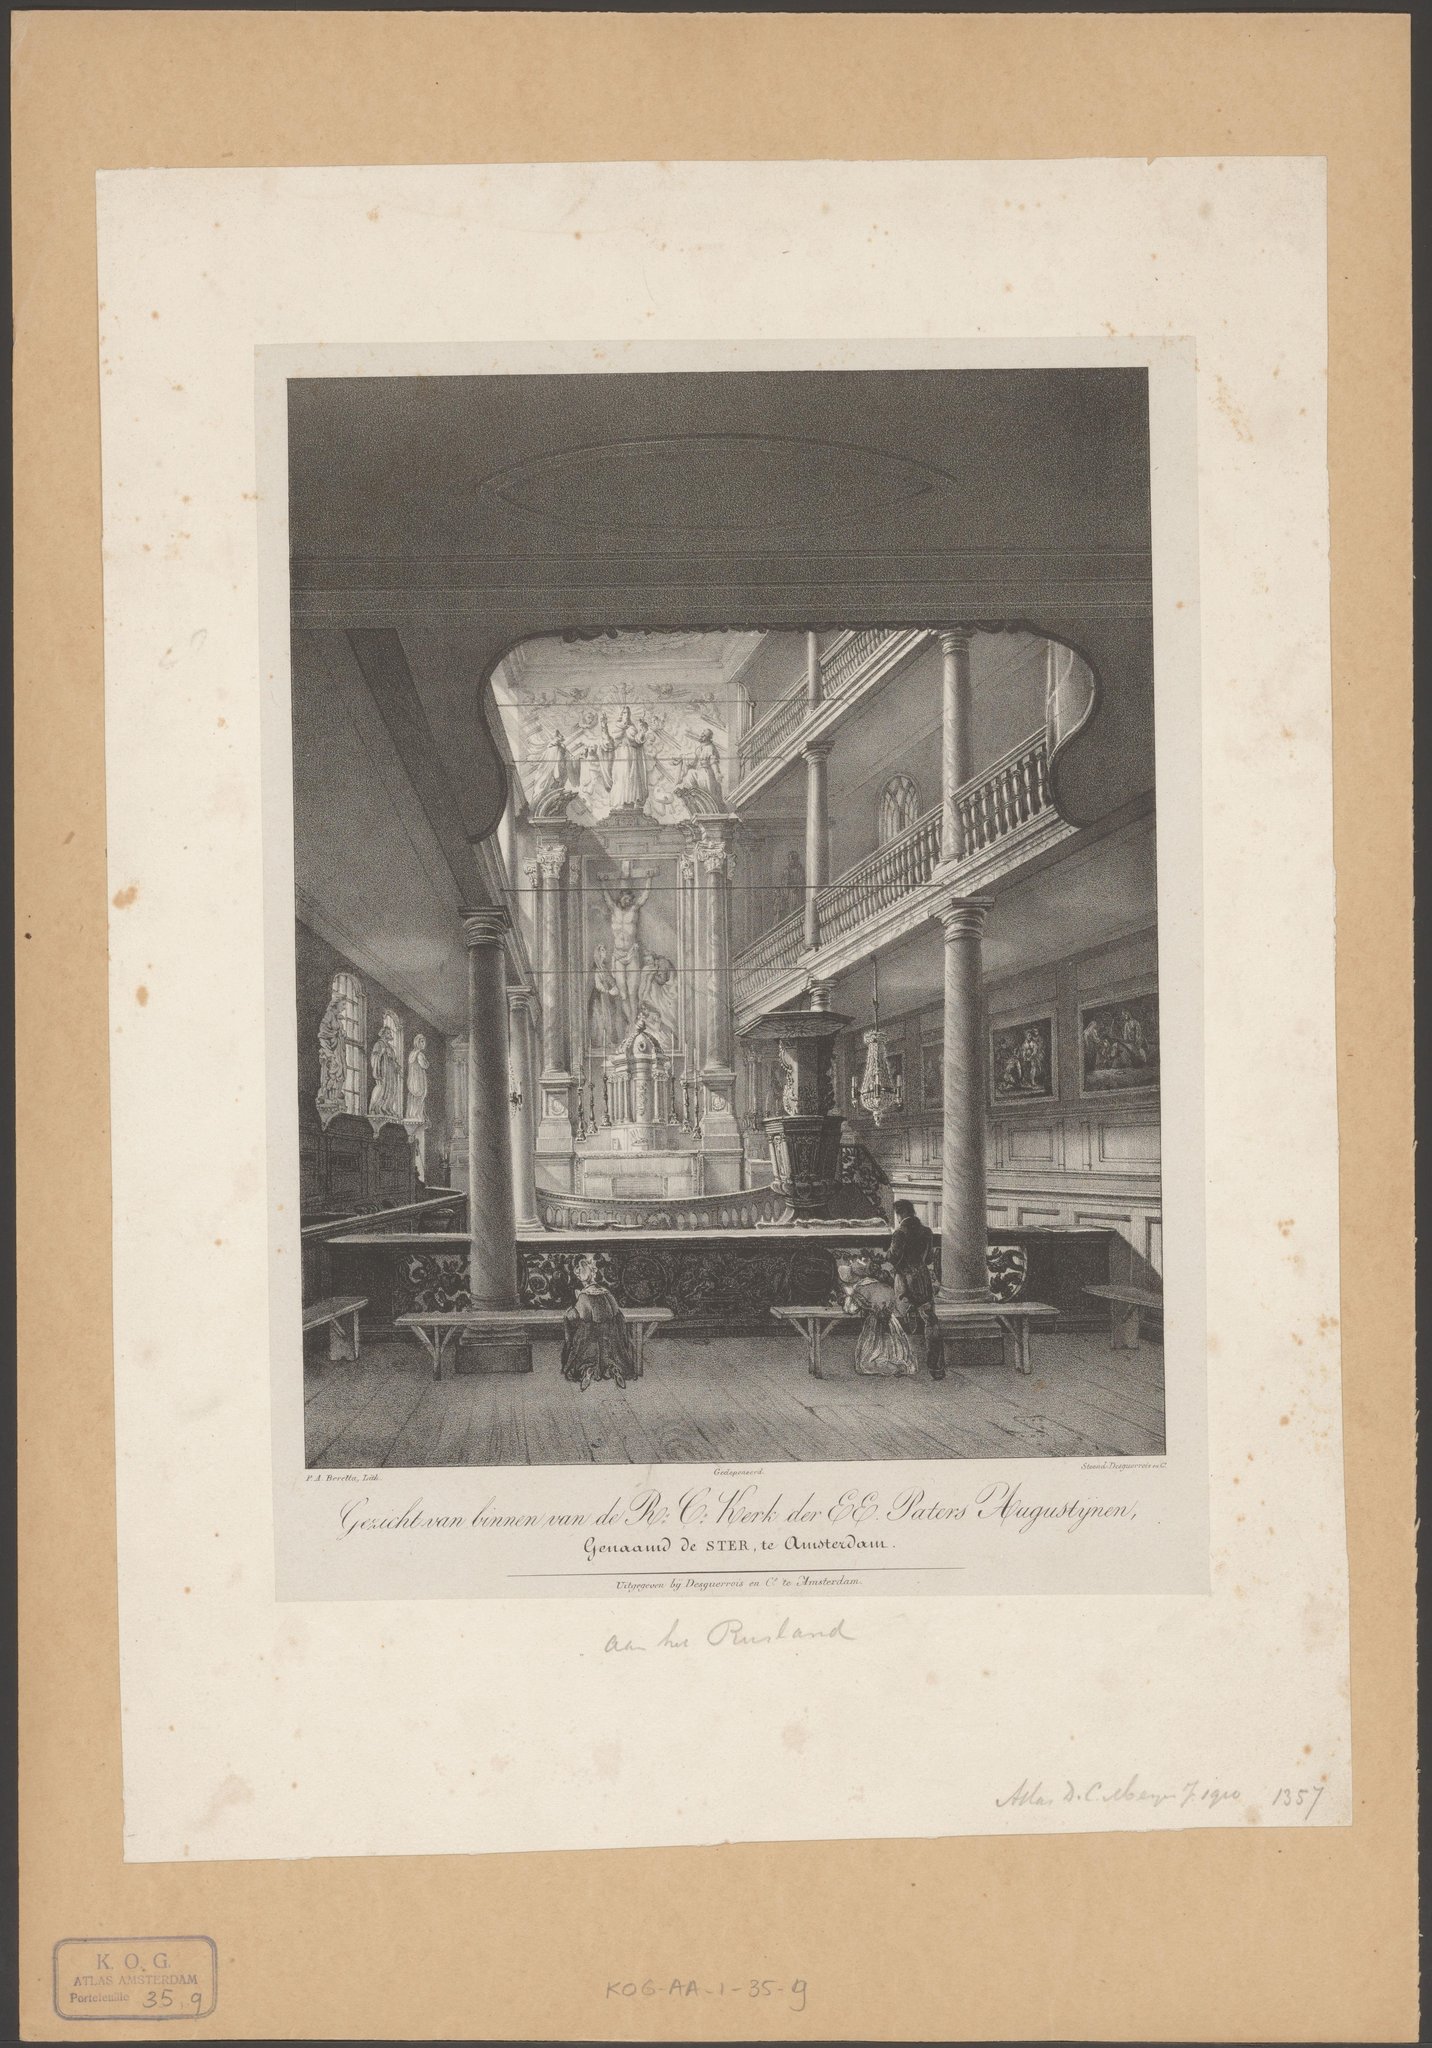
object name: print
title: Gezicht van binnen van de R:C: Kerk der EE. Paters Augustijnen, genaamd de Ster, te Amsterdam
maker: petrus augustus beretta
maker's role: draughtsman, print maker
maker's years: 1805-1866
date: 1815-1866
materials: paper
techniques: lithograph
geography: amsterdam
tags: (public) prayer, interior of church, altar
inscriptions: collector's mark: ‘35,9’ Lugt 1641b, : ‘Gedeponeerd.’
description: Ook wel bekend als De Ster of De Spin. Onderwerpsrubriek binnen de Atlas Amsterdam: R.K. Gemeenten: Sint Nicolaaskerk t/m Willibrordus (Rustenburgerstraat).